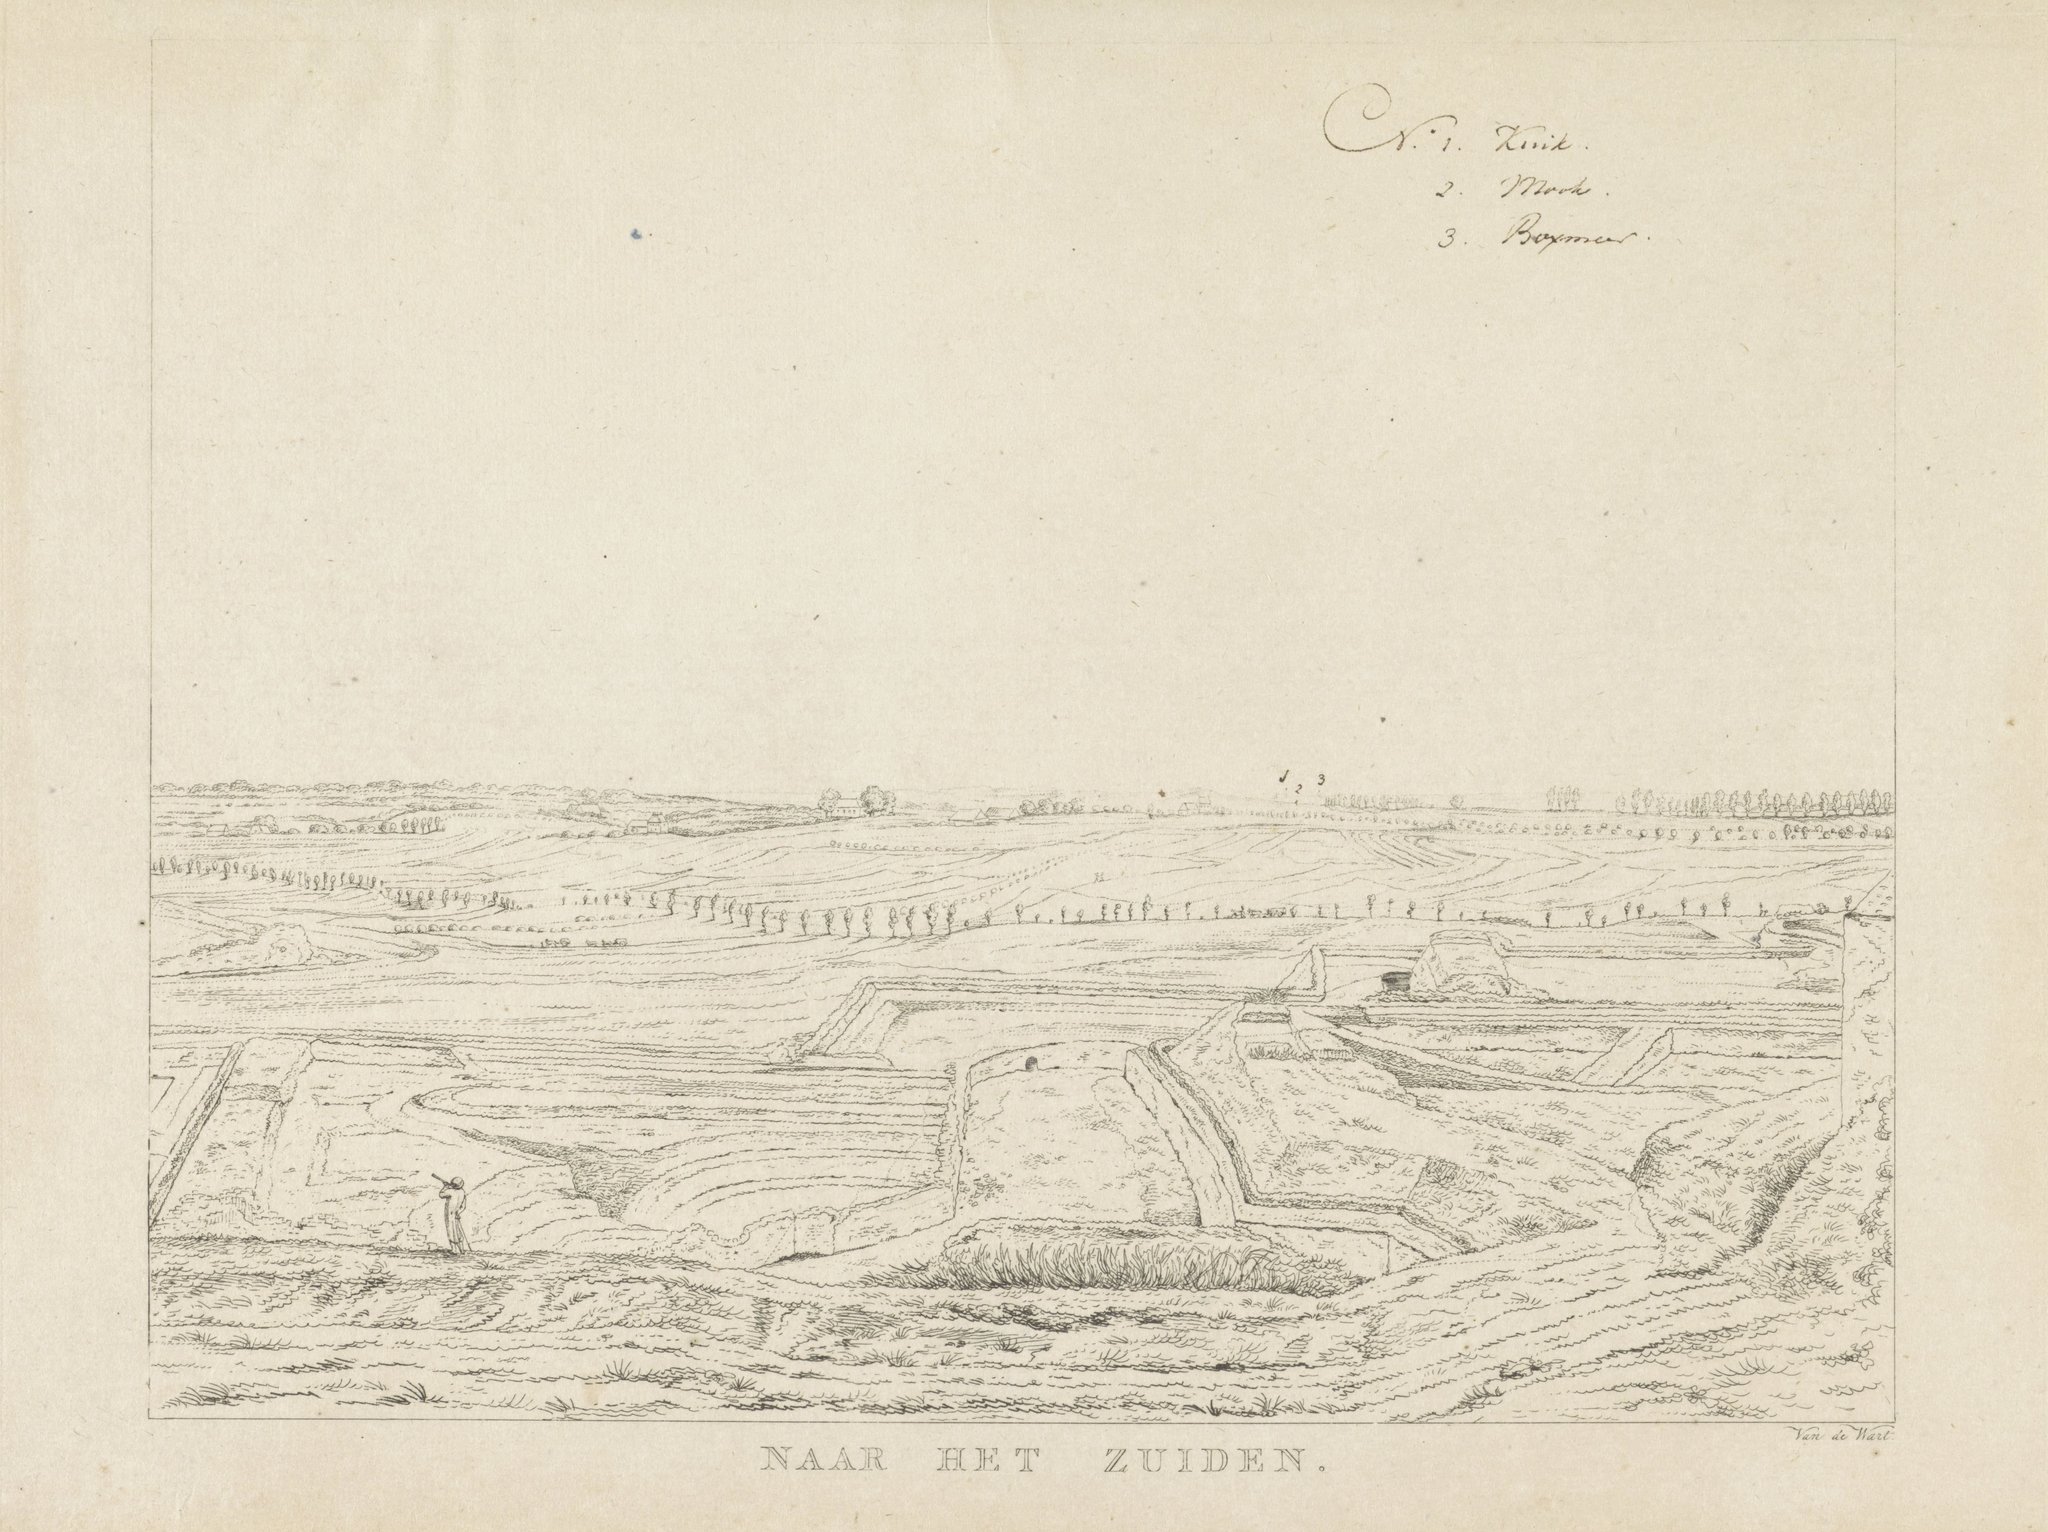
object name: print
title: Geldersch panorama of rondgezicht naar het leven geteekend op belvedére te Nymegen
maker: derk anthony van de wart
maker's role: draughtsman, painter, print maker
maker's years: 1767-1824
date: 1815-1824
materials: ink, paper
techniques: etching, pen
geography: nijmegen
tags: landscapes, fence, wall, paling, nijmegen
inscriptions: inscription: ‘No. 1. Kuik. 2. Mook. 3. Boxmeer.’, collector's mark: Lugt 2228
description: Glooiend landschap ten zuiden van Nijmegen met een muur. In de verte zijn de steden Cuijk, Mook en Boxmeer met nummers aangeduid. De prent is een onderdeel van een suite van negen prenten, inclusief de titelprent.